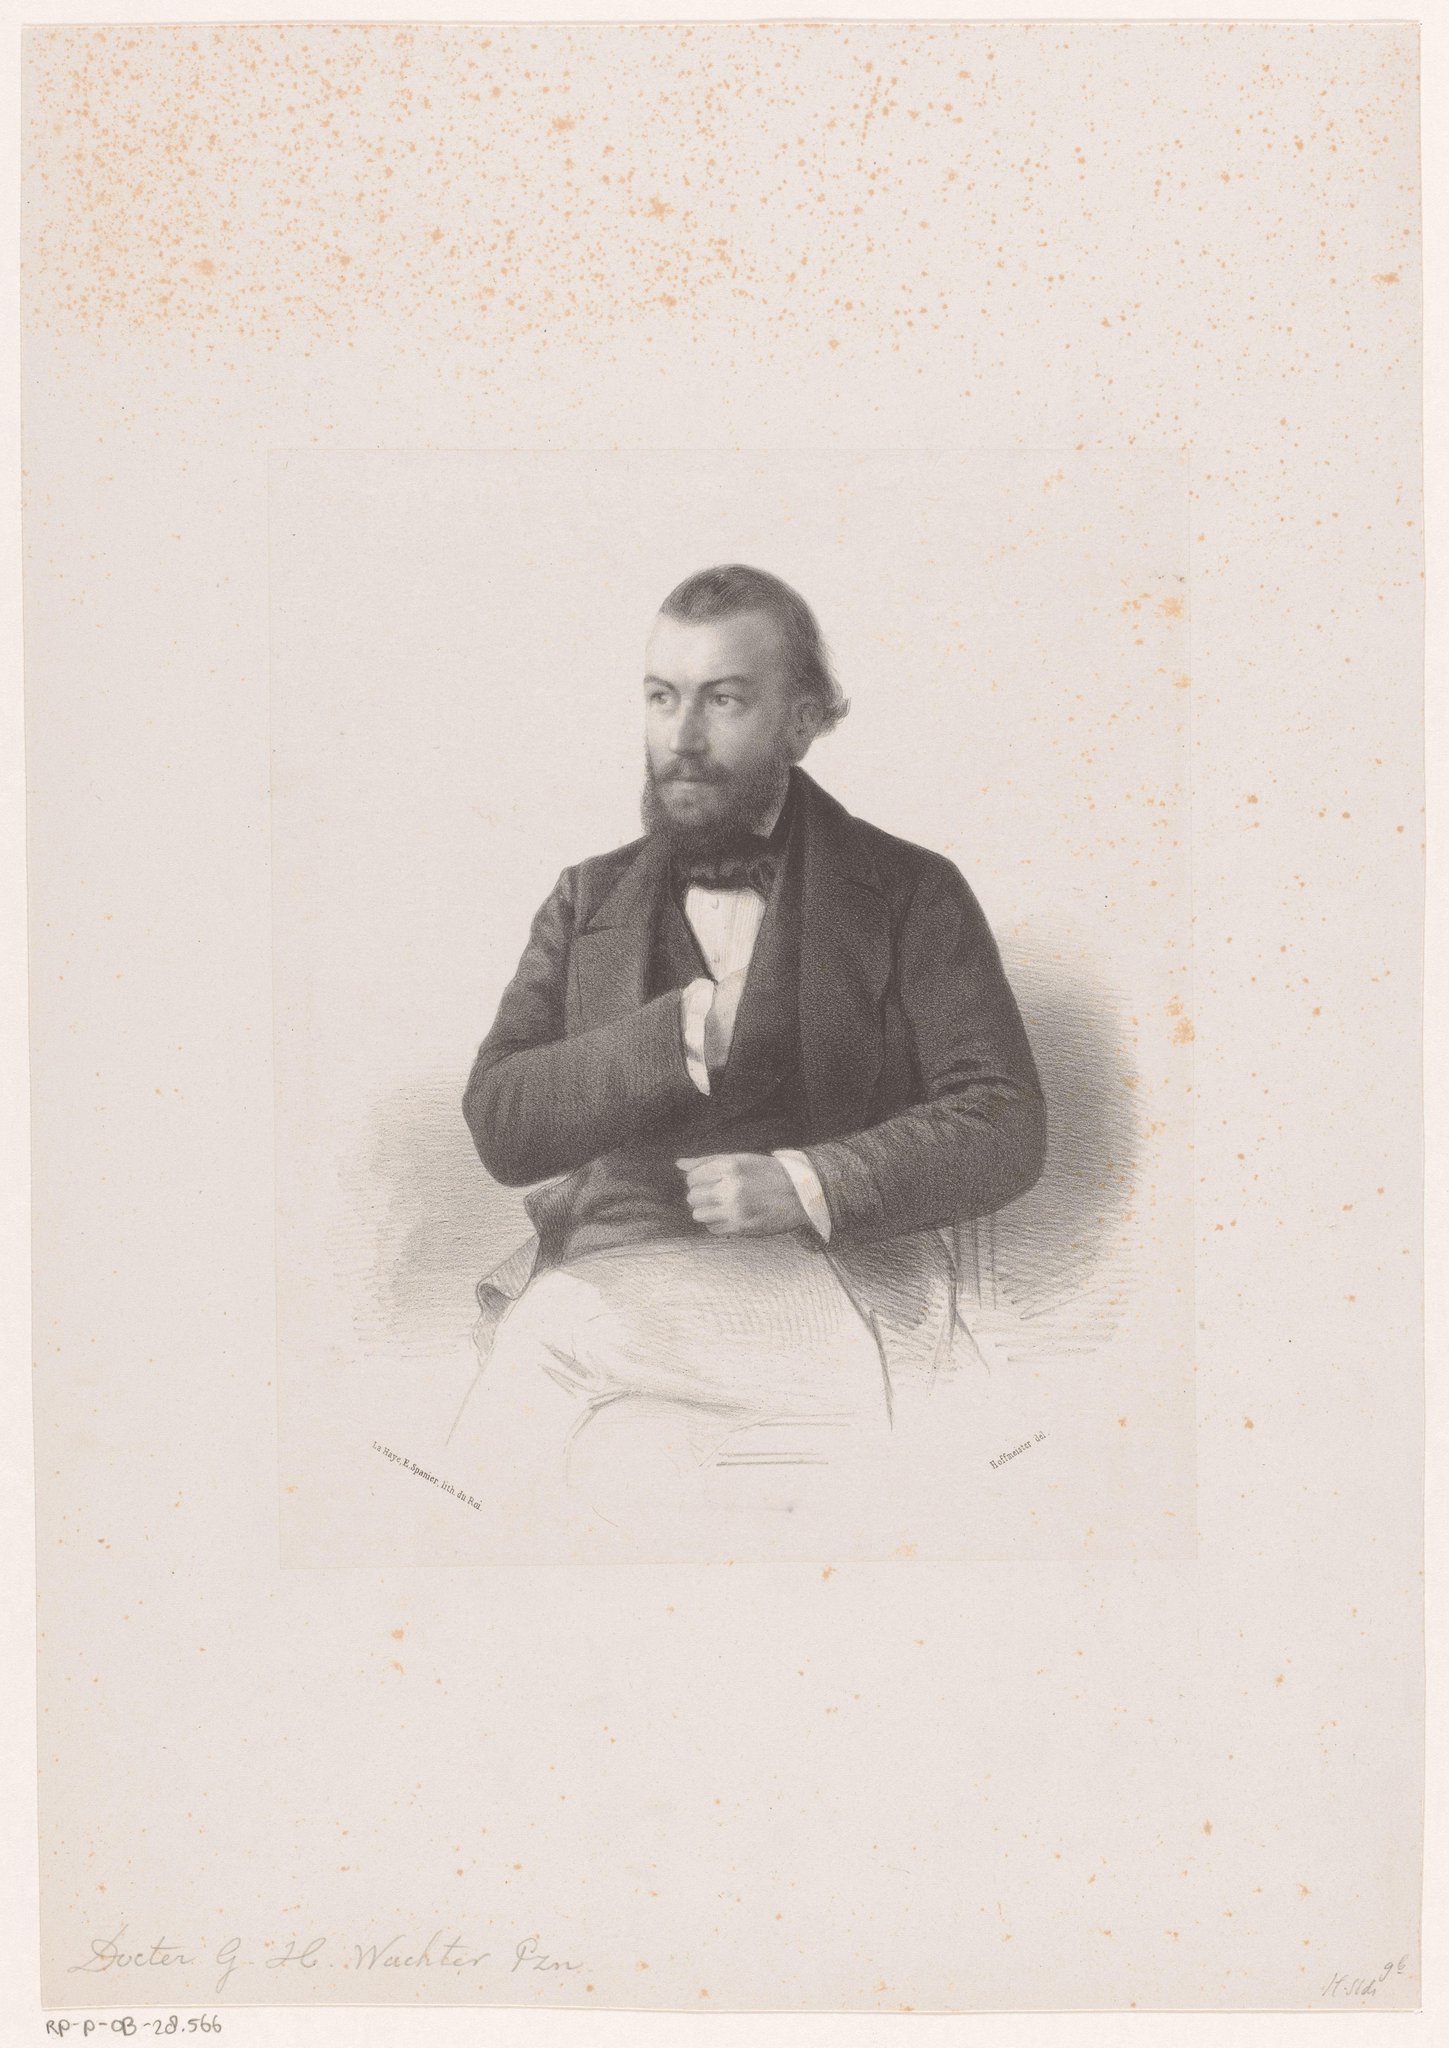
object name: print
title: Portret van George Hendrik Wachter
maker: johan hendrik hoffmeister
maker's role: print maker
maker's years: 1823-1904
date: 1851-1883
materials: paper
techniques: lithograph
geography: the hague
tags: rotterdam, the hague, historical persons (+ (full) bust portrait)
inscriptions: collector's mark: Lugt 2228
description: De geportretteerde heeft zijn rechterhand in zijn vest gestoken.